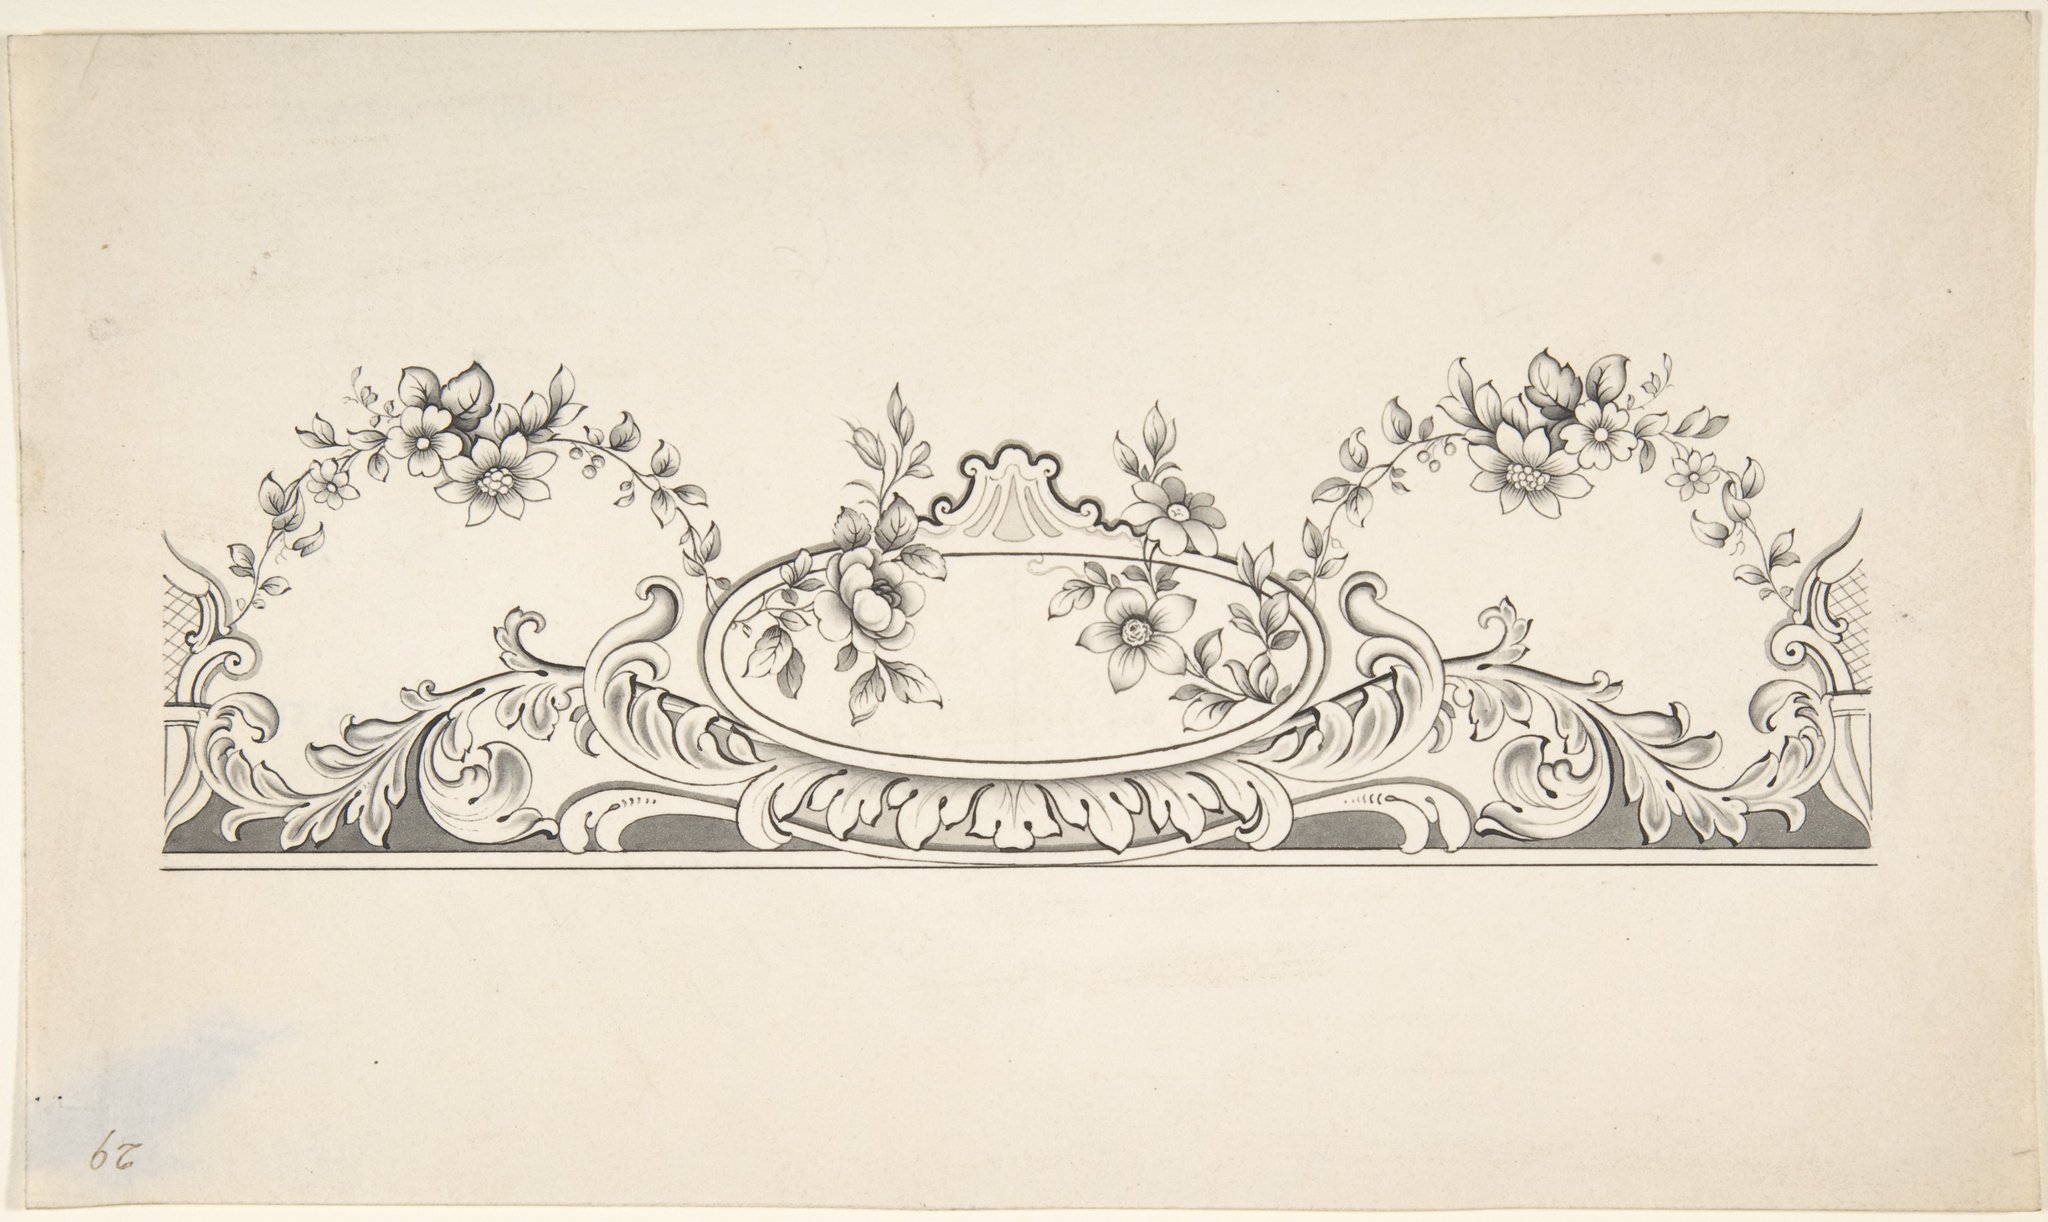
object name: drawing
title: Design for Panel Decoration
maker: j. hulme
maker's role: artist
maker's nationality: british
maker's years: 1800-1880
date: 1828-1840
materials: ink, watercolor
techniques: pen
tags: ornament